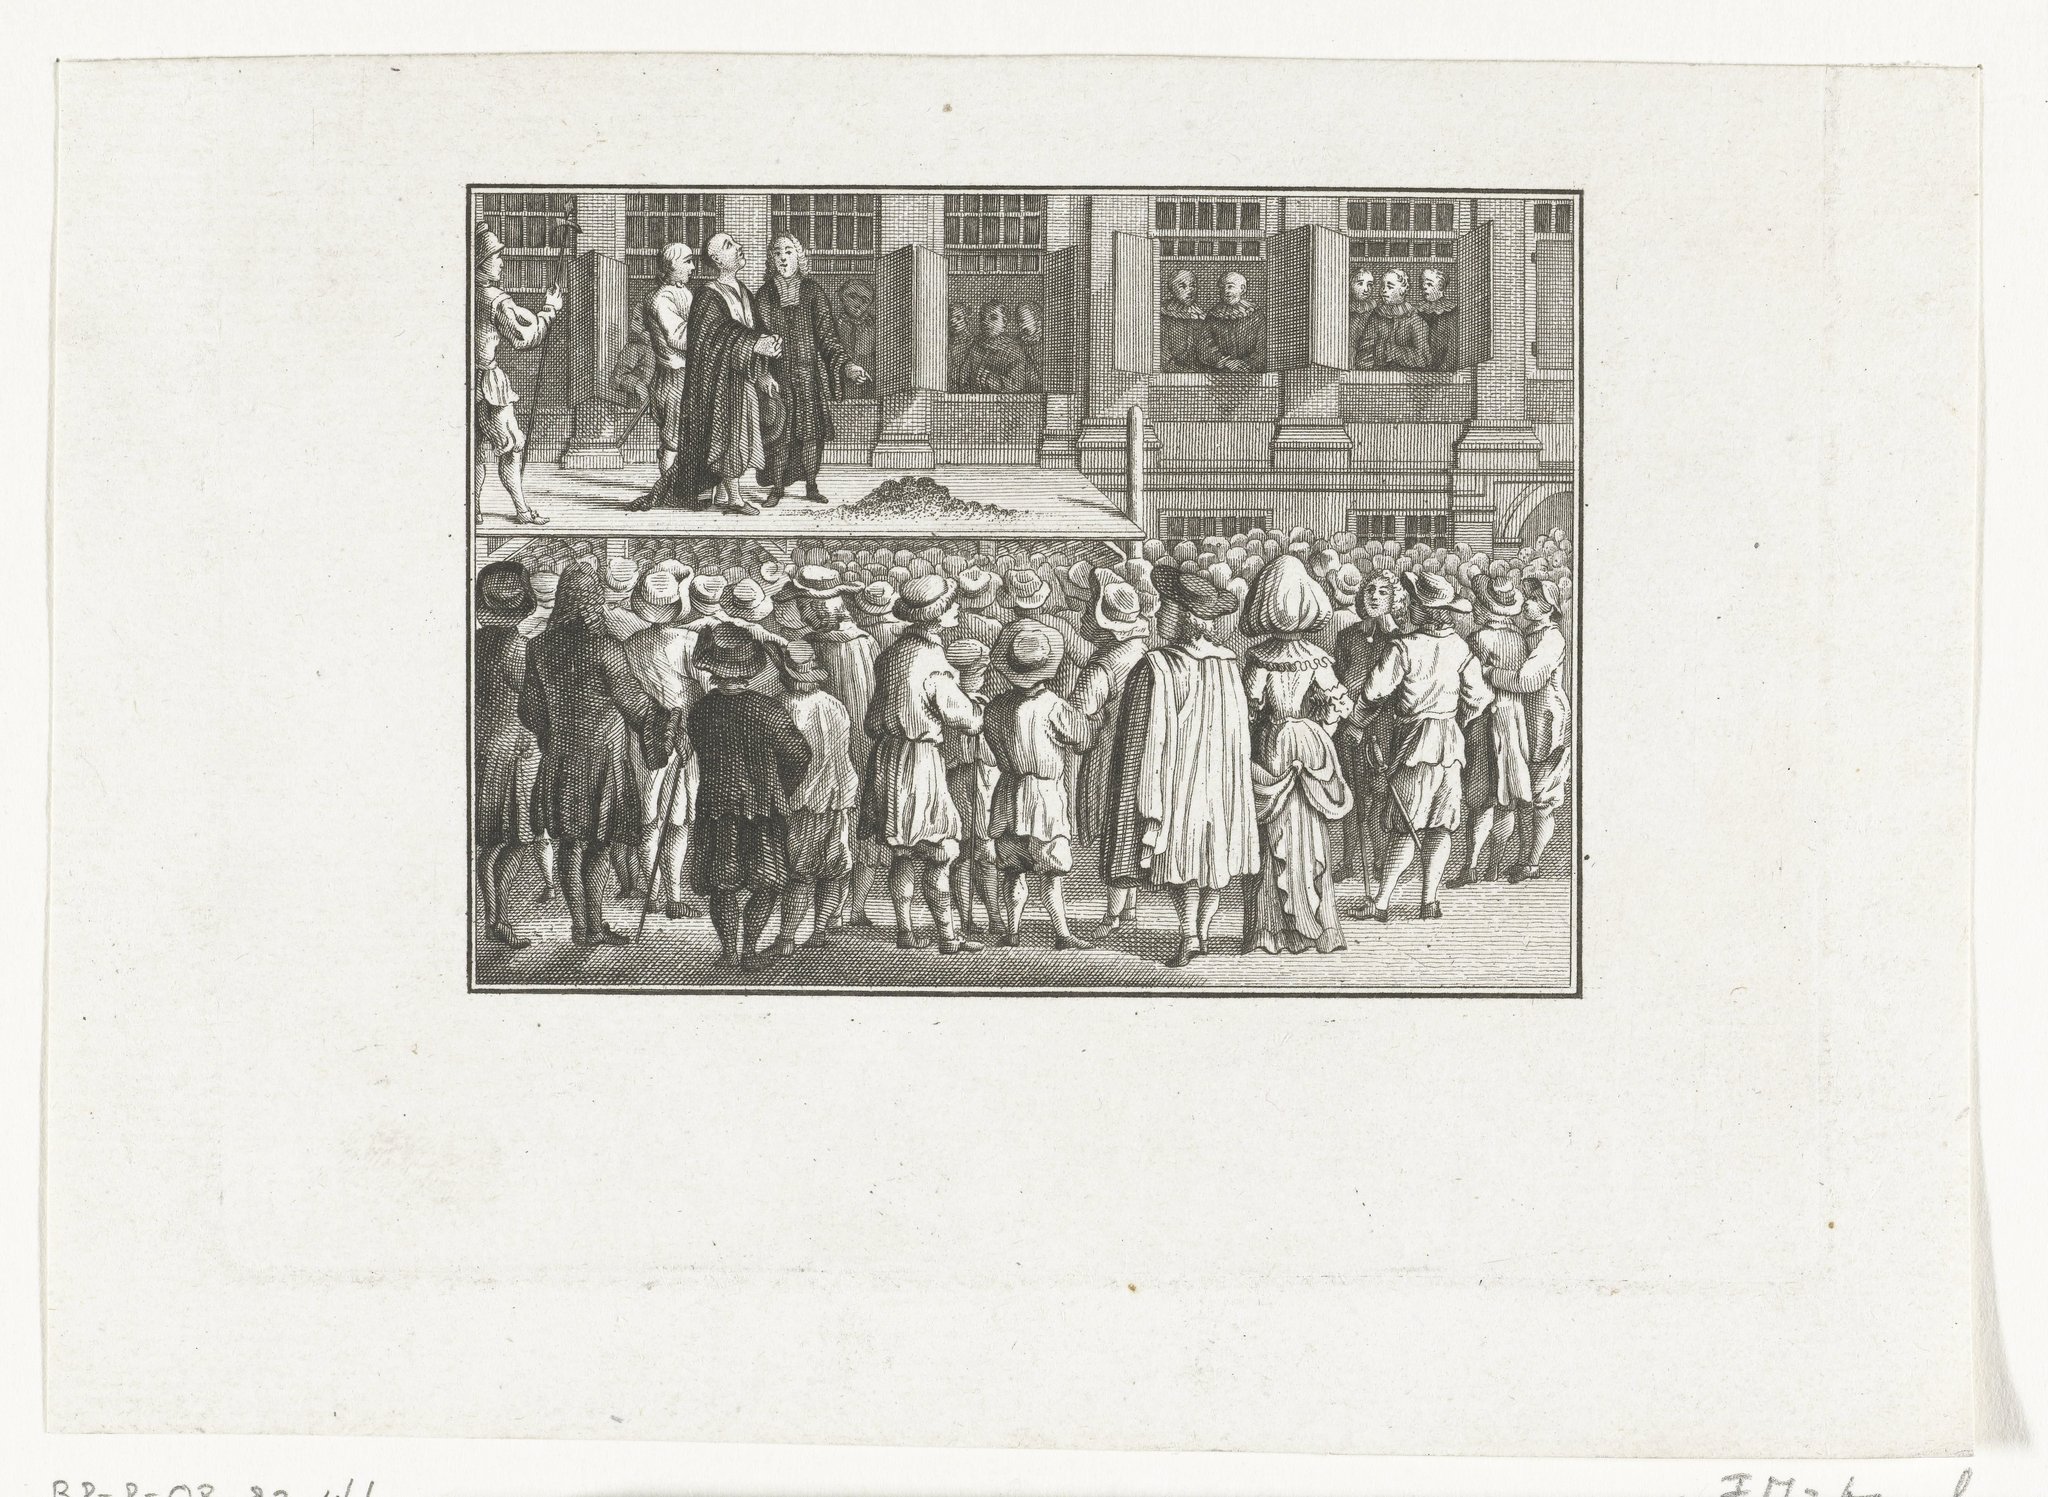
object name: print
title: Executie van kapitein Bont, 1677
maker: barent de bakker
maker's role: print maker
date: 1780-1782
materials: paper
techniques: etching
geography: northern netherlands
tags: amsterdam, on the scaffold or place of execution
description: Executie van kapitein Jan Bont op 5 februari op het Admiraliteits- of Prinsenhof aan de Oudezijds Voorburgwal te Amsterdam. Veroordeeld wegens ongeoorloofd verlaten van de vloot van Jacob Binckes in West-Indië. Bont staande op het schavot voor zijn onthoofding.